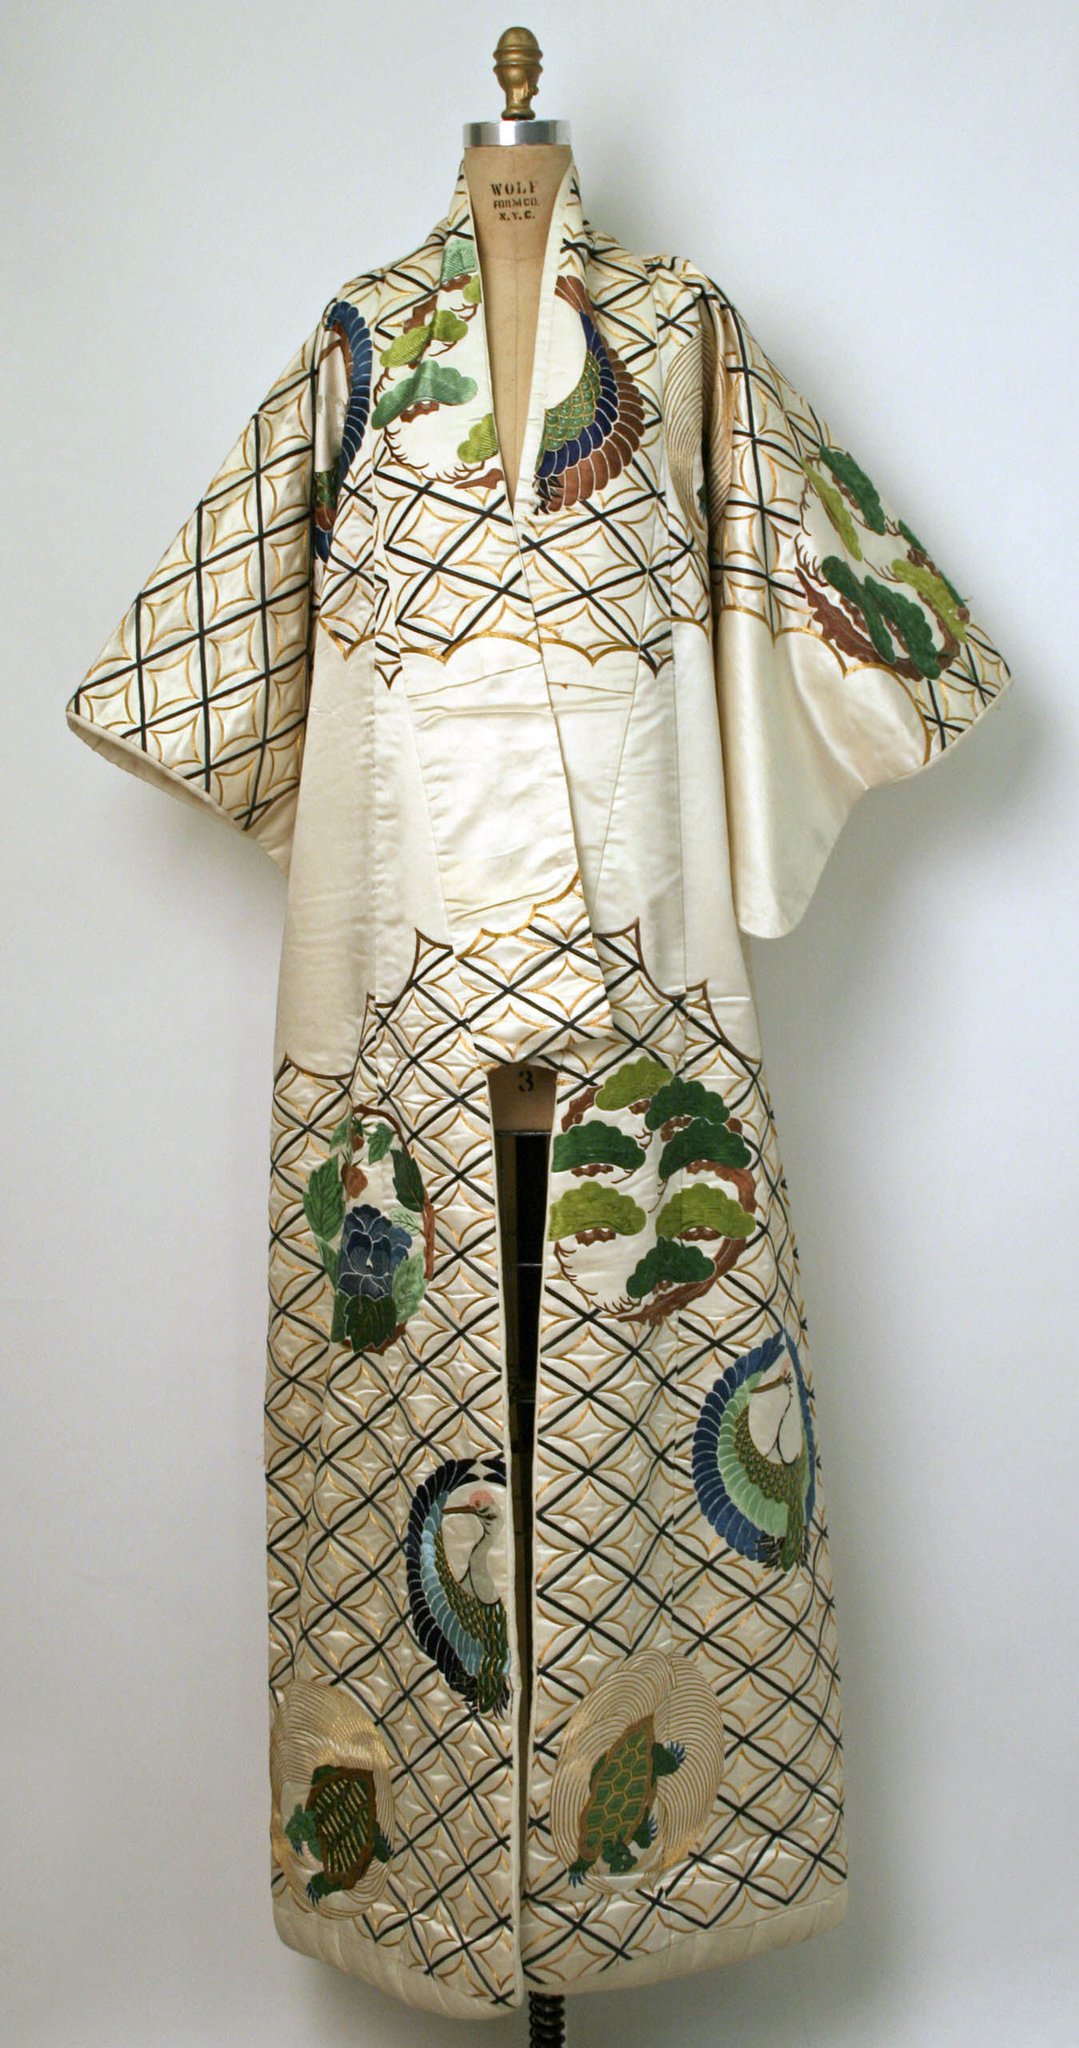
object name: kimono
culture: japanese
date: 1800-1941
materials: silk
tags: birds,turtles